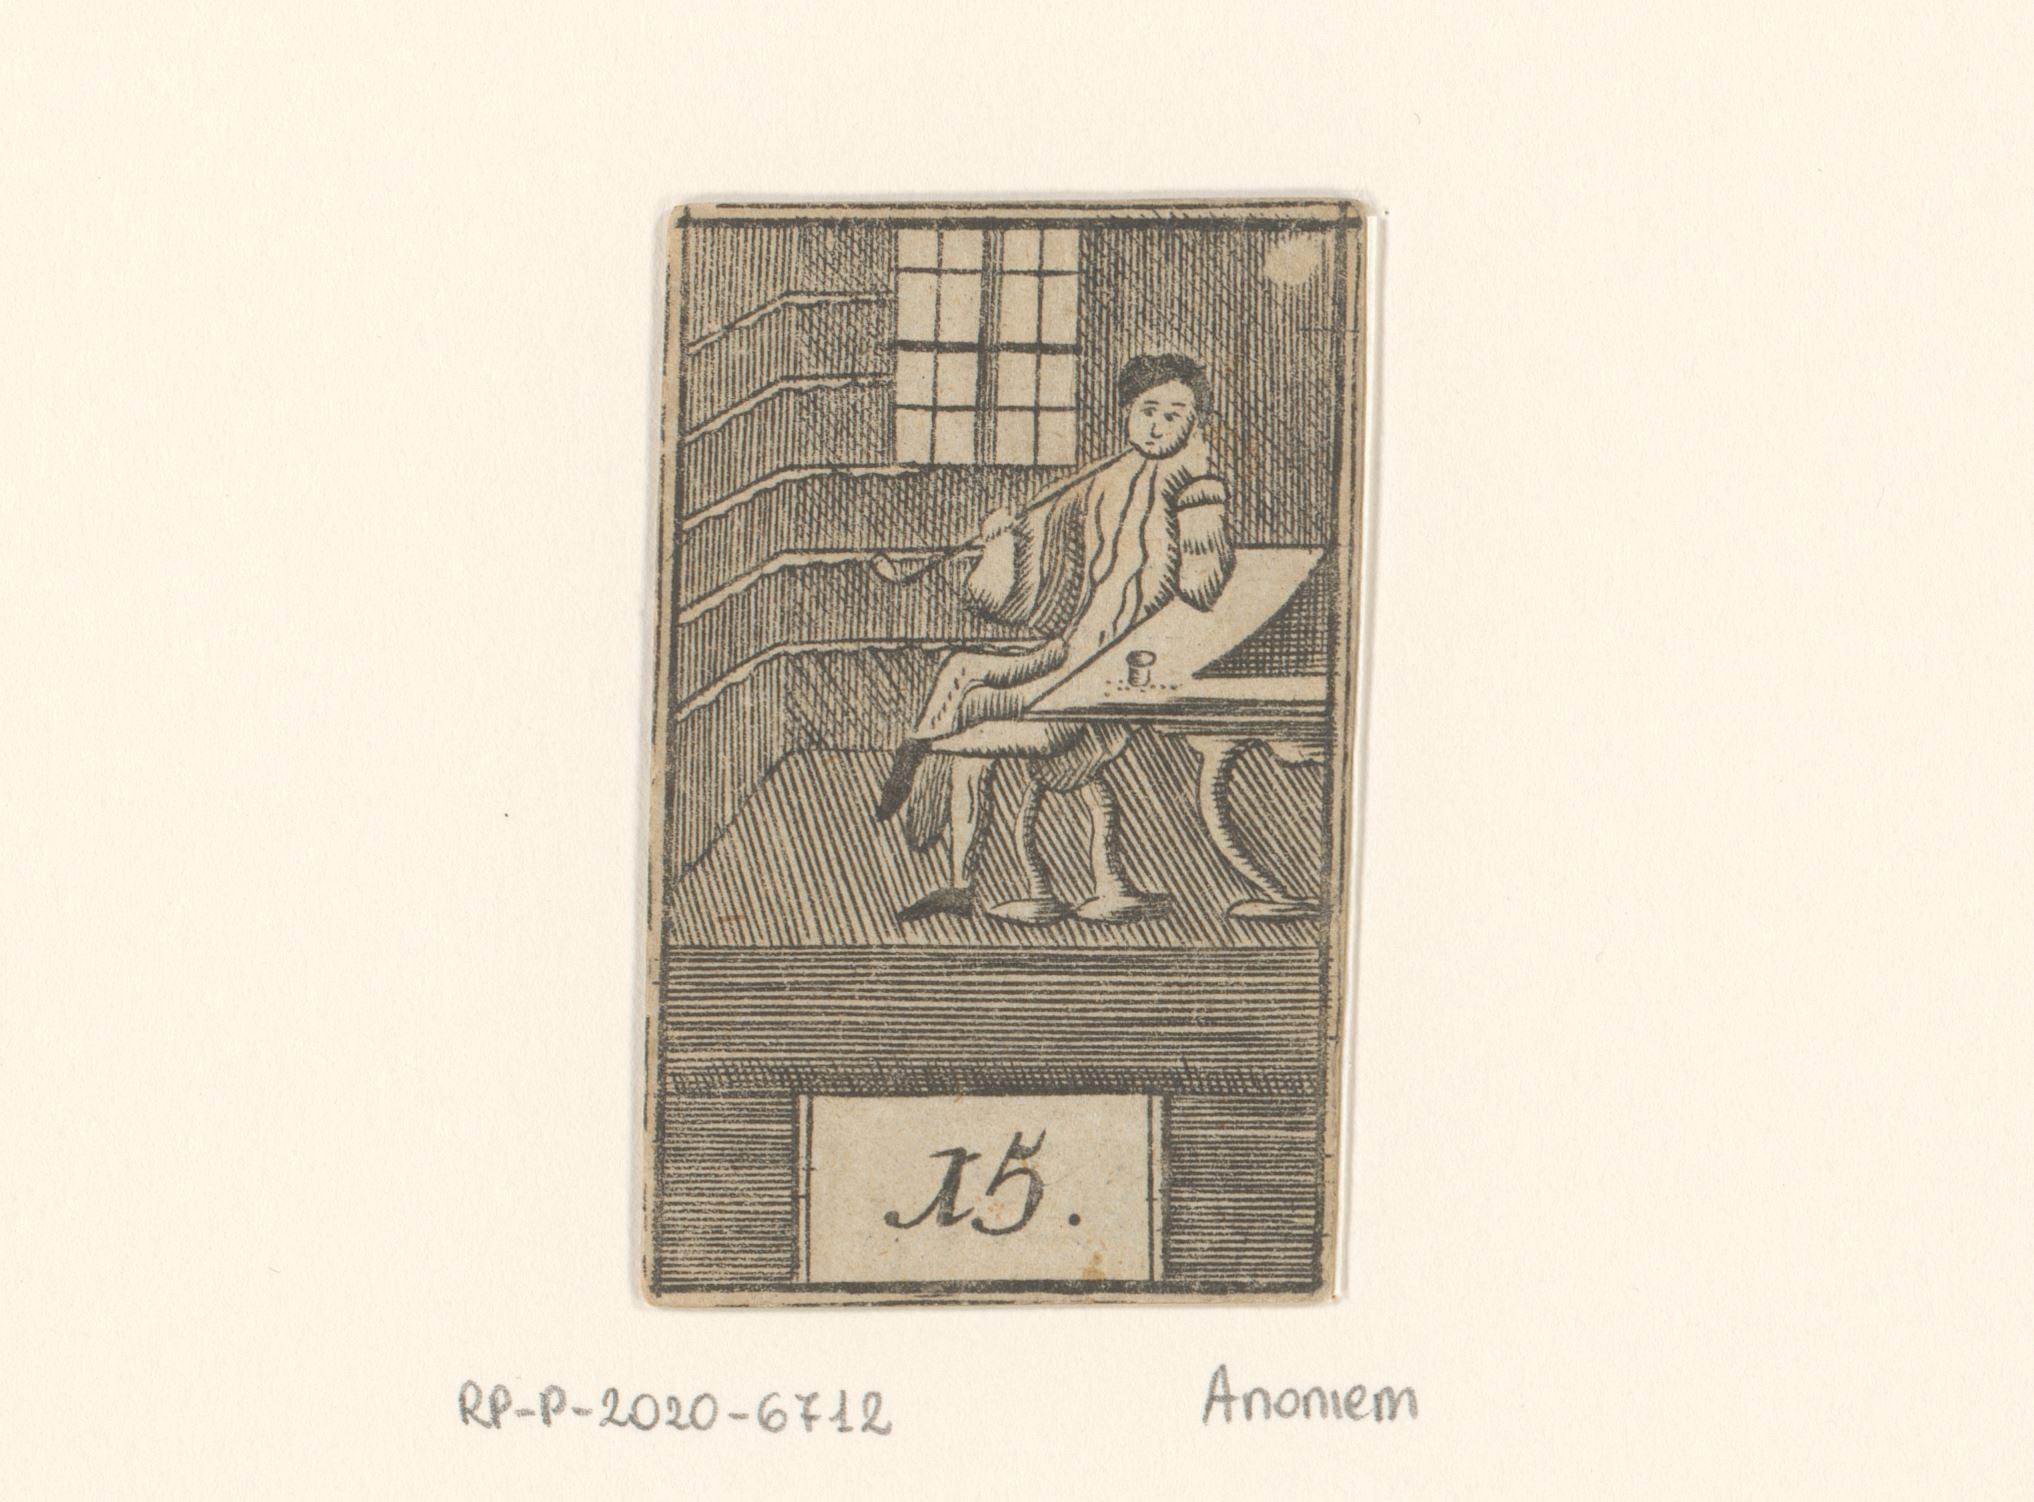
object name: print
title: Pijprokende man zittend aan een tafel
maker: Anonymous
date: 1700-1800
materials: paper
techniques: engraving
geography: northern netherlands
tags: pipe ~ tobacco (+ taking (particular) foodstuffs: eating, drinking, smoking, chewing, etc.)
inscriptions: collector's mark: Lugt 2228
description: Prent is vermoedelijk onderdeel van een spel, zie ook RP-P-2020-2614 en RP-P-2020-2613.